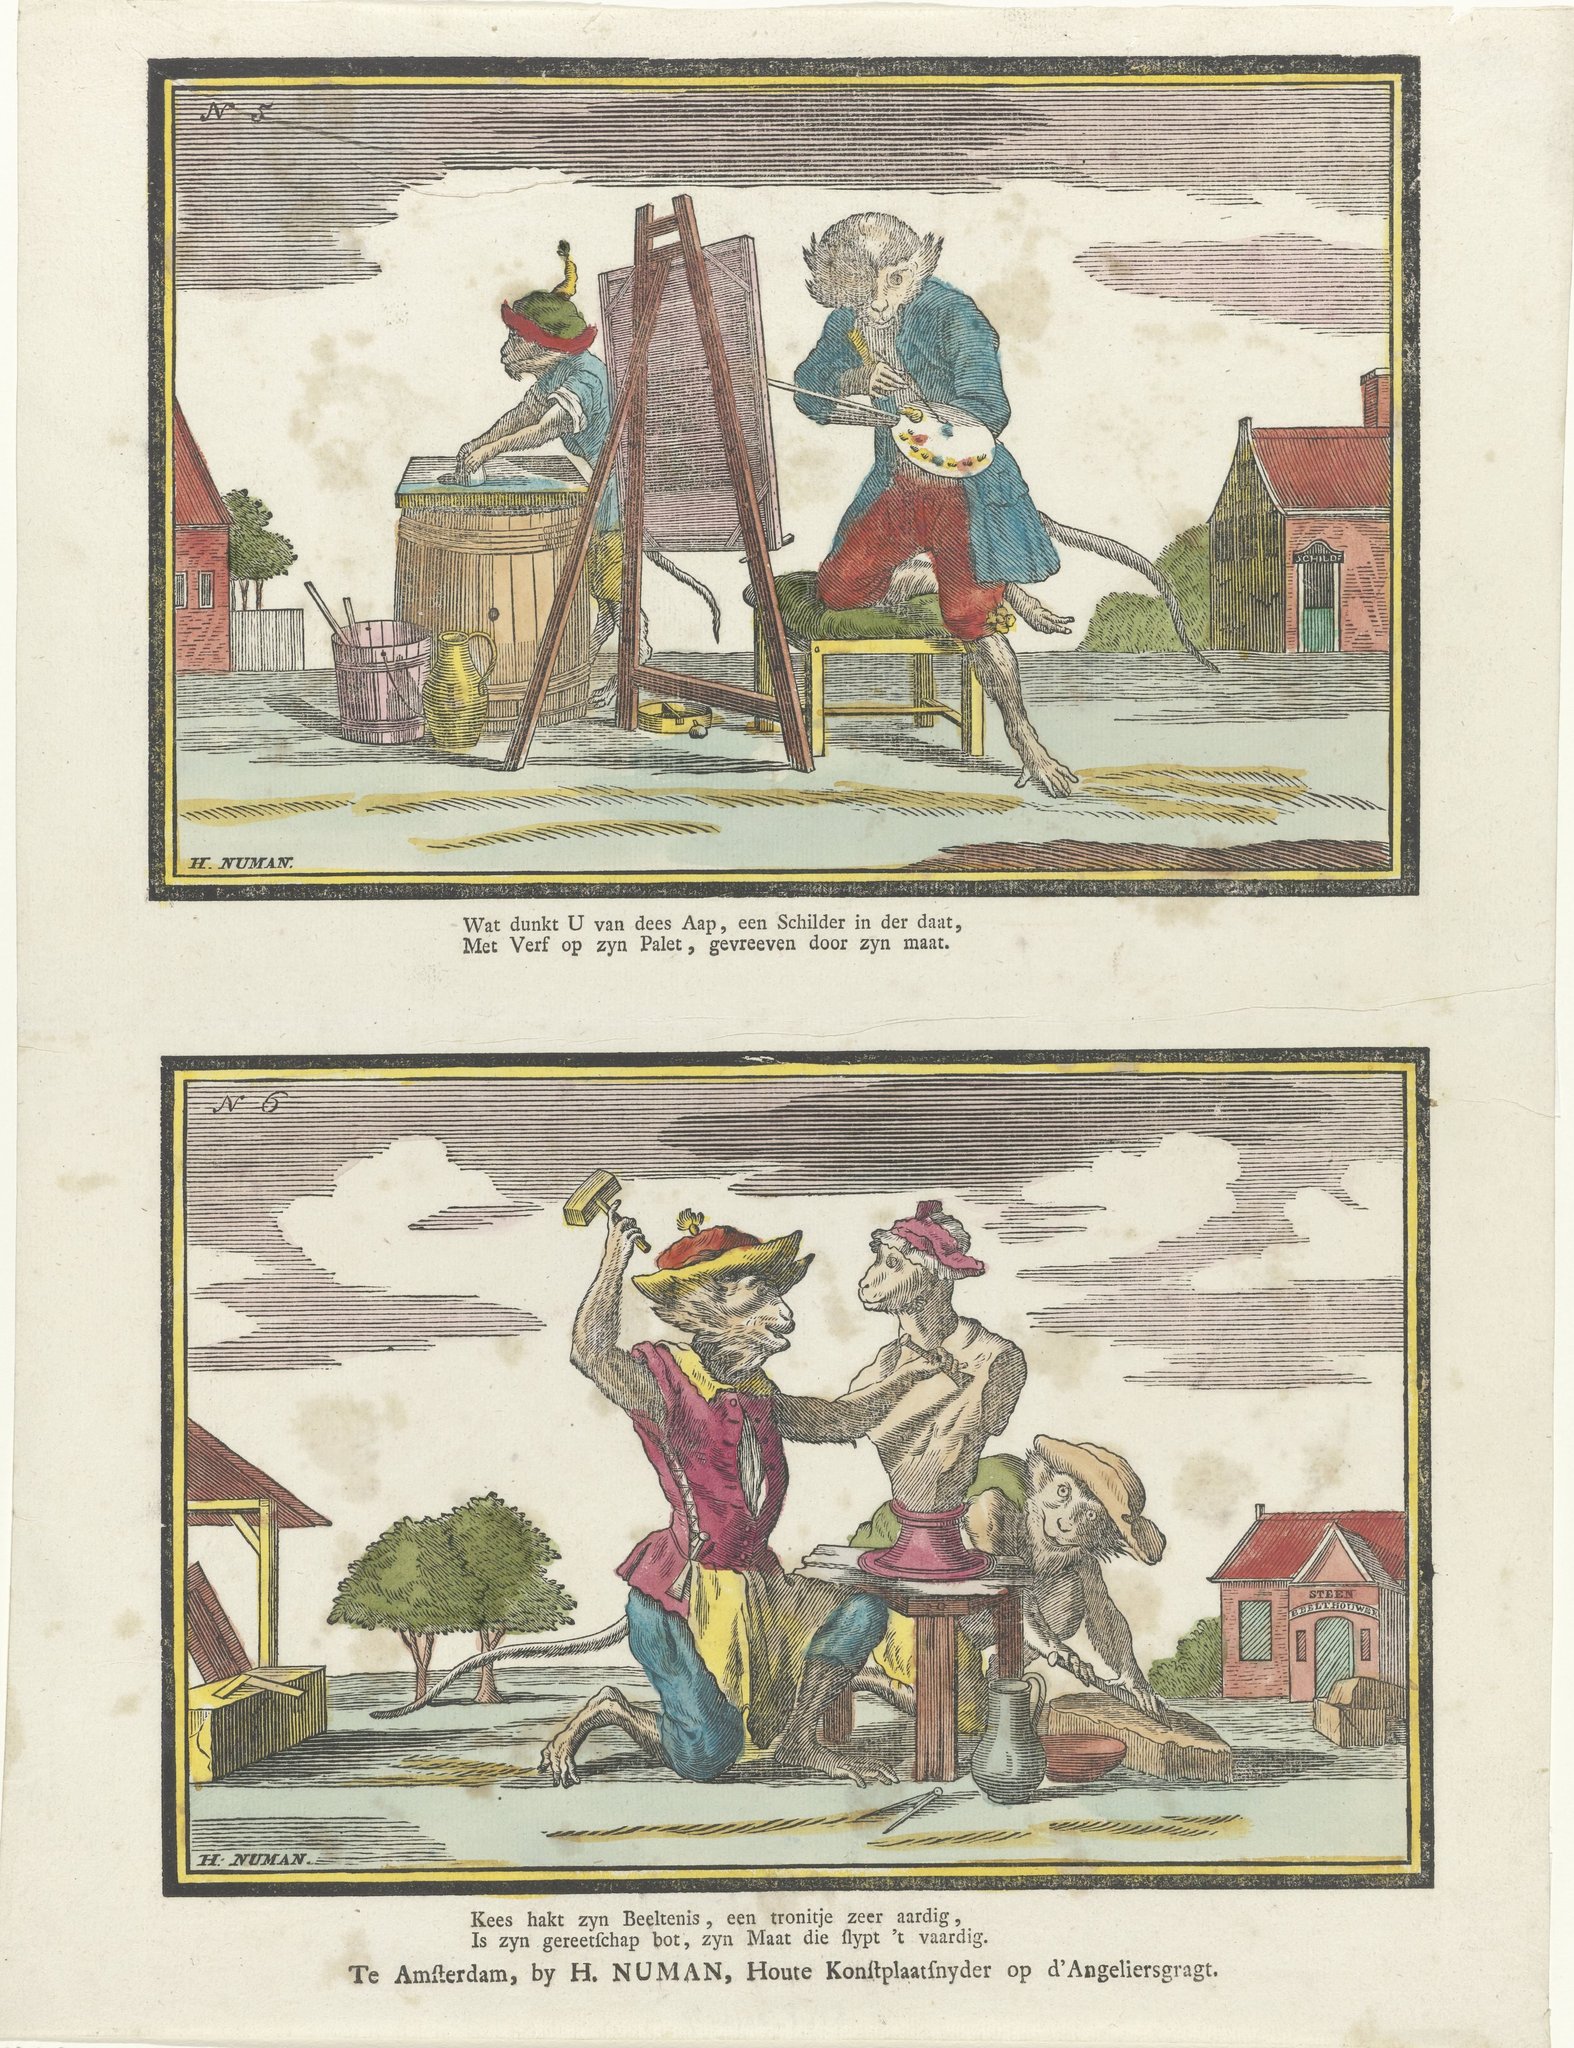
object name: popular print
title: Apen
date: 1760-1788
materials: paper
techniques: colour, letterpress printing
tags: sculptor at work, painting ~ applied arts, monkeys, apes, painter preparing colours - cc - out of doors, animals acting as human beings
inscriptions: collector's mark: Lugt 2228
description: Blad met 2 voorstellingen. Boven: (genummerd N 5) een aap die verf maakt op een grote houten ton en een aap die schildert met palet en penselen achter een schildersezel met doek. Onder: (genummerd N 6) twee apen aan het beeldhouwen. Beide voorstellingen spelen zich af in de buitenlucht met gebouwen op de achtergrond. Onder elke voorstelling een tweeregelig vers.